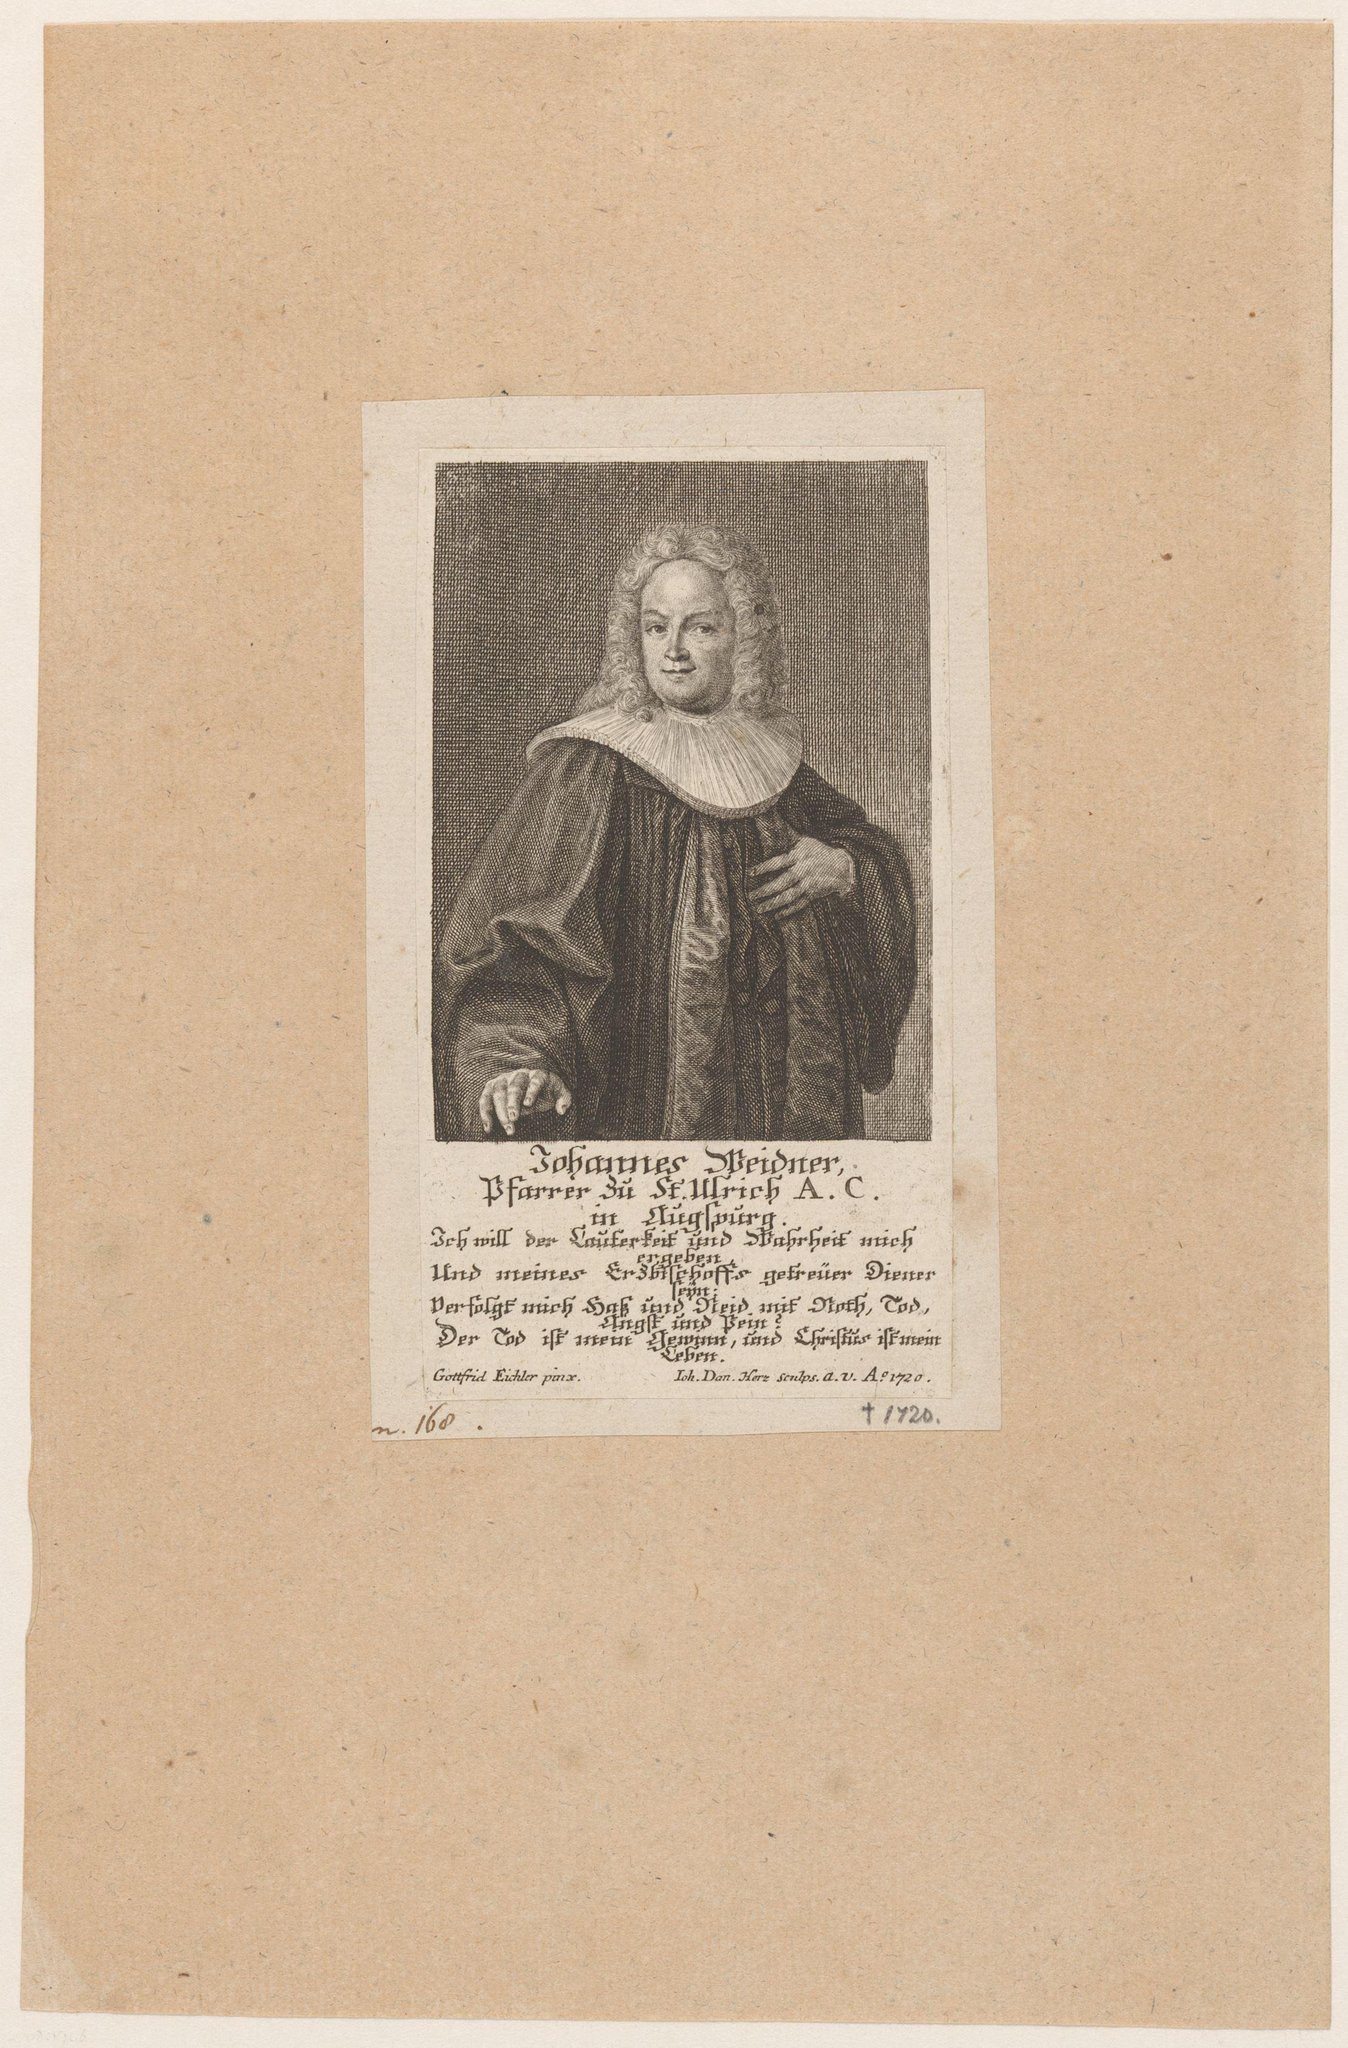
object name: print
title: Portret van Johann Weidner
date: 1720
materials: paper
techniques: engraving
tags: augsburg, clergyman, theologian, historical persons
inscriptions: collector's mark: Lugt 2228